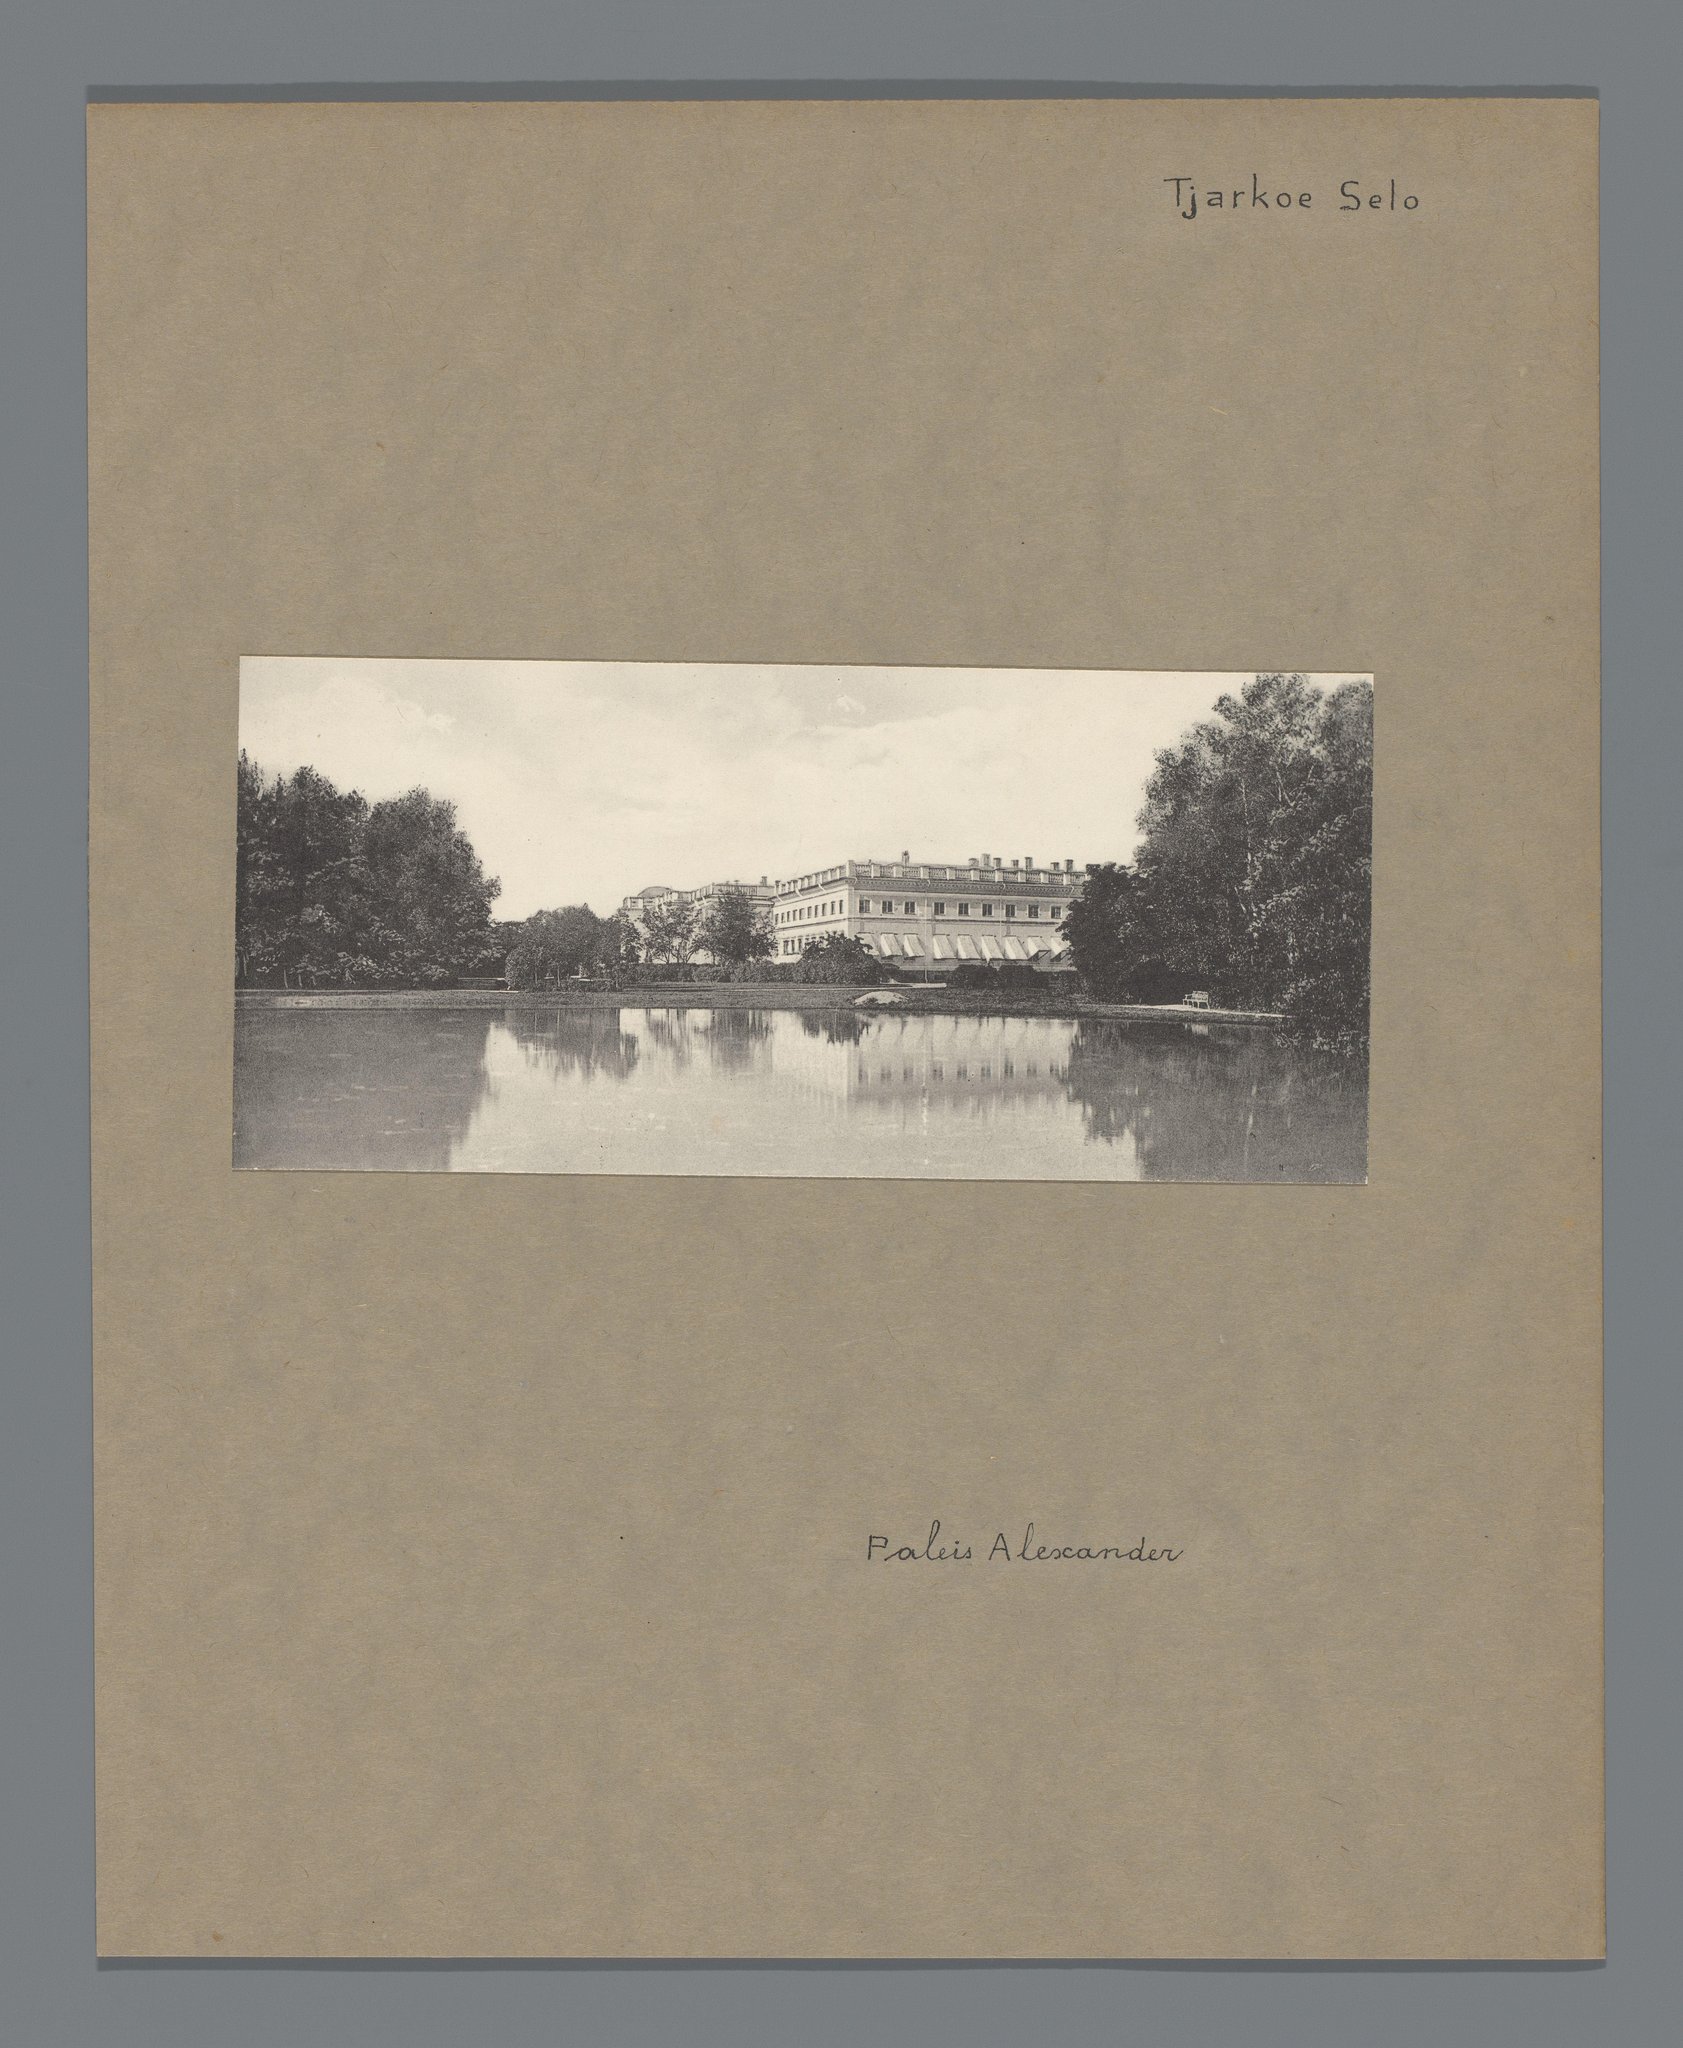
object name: photograph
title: Palais Alexander. Tjarkoe Selo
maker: Anonymous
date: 1860-1925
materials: photographic support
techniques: photograph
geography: russia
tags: russia